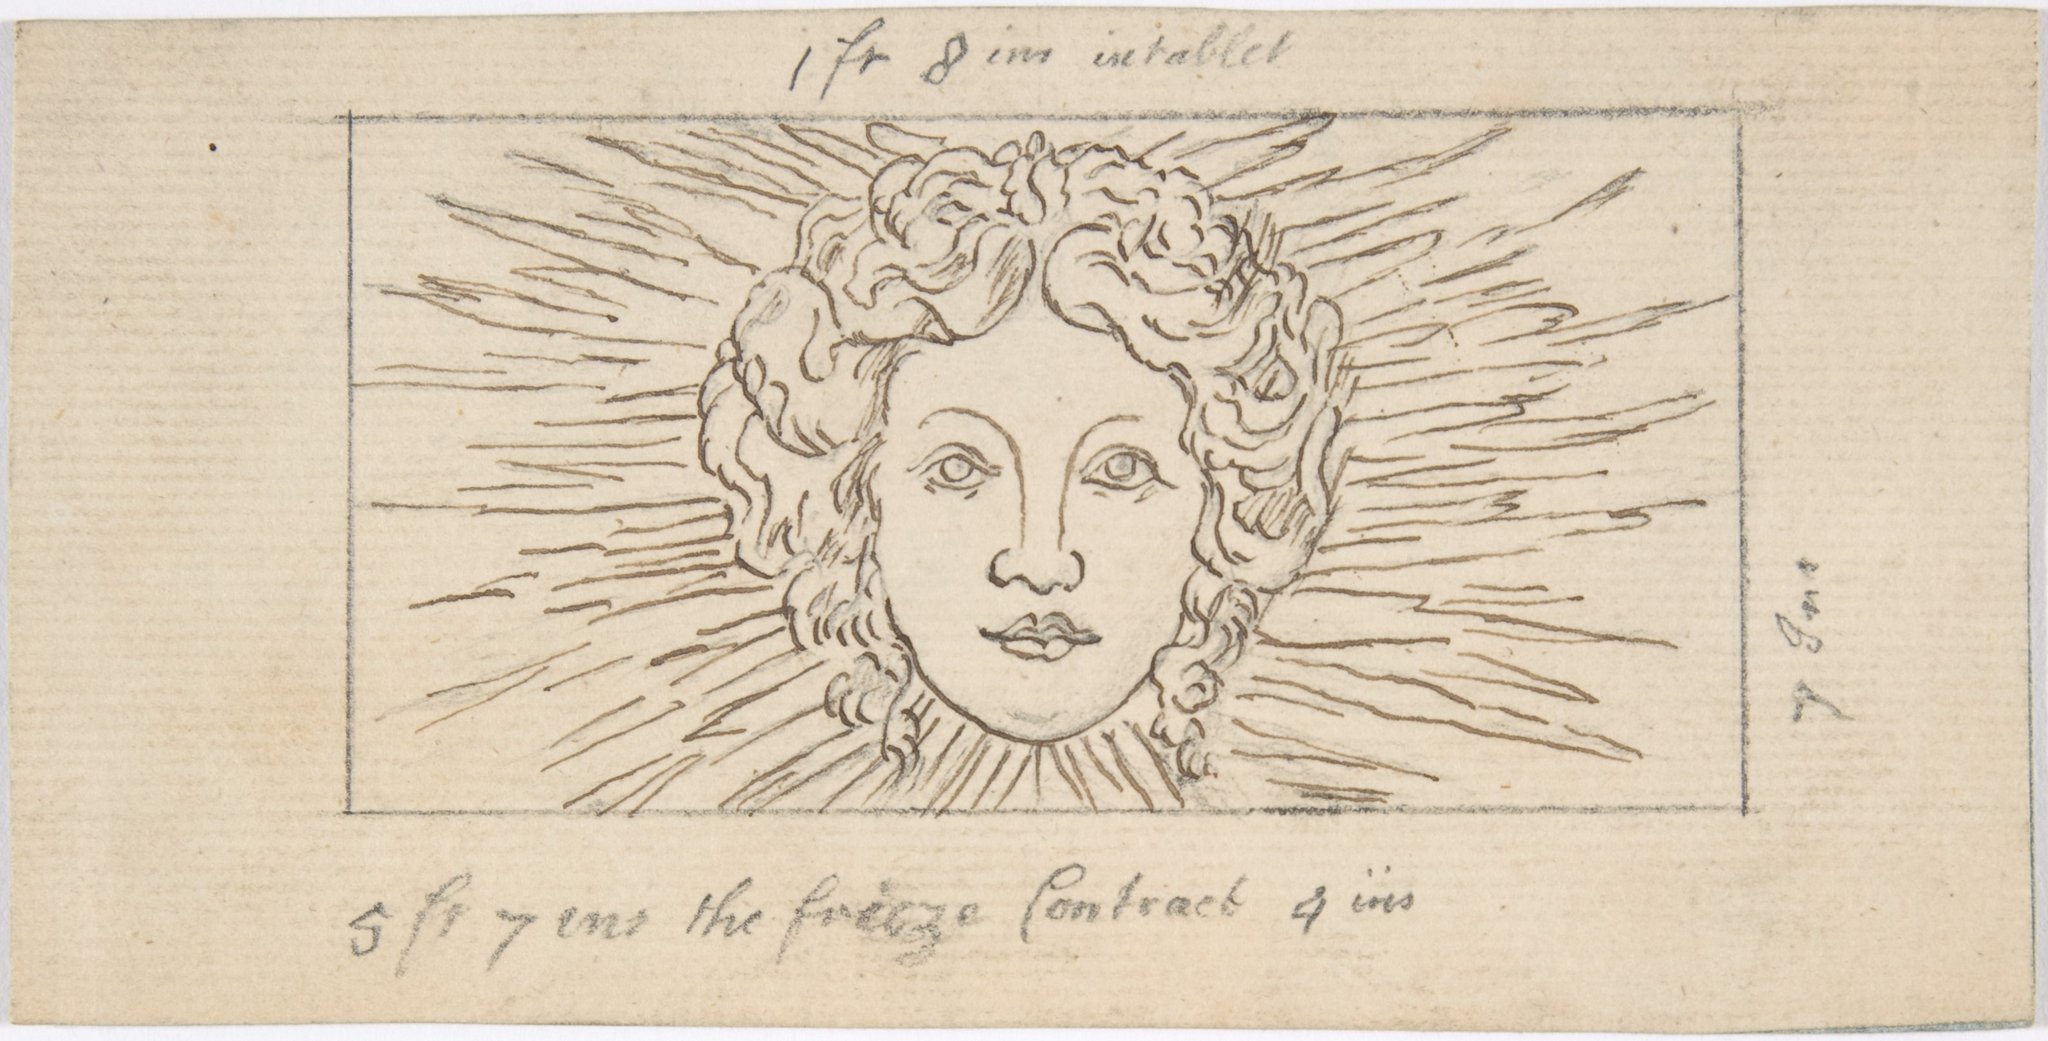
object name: drawing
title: Head of Apollo in Glory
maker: anonymous, british, late 18th–early 19th century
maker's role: artist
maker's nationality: british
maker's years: 1771-1835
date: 1767-1833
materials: graphite, ink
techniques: pen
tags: heads,apollo